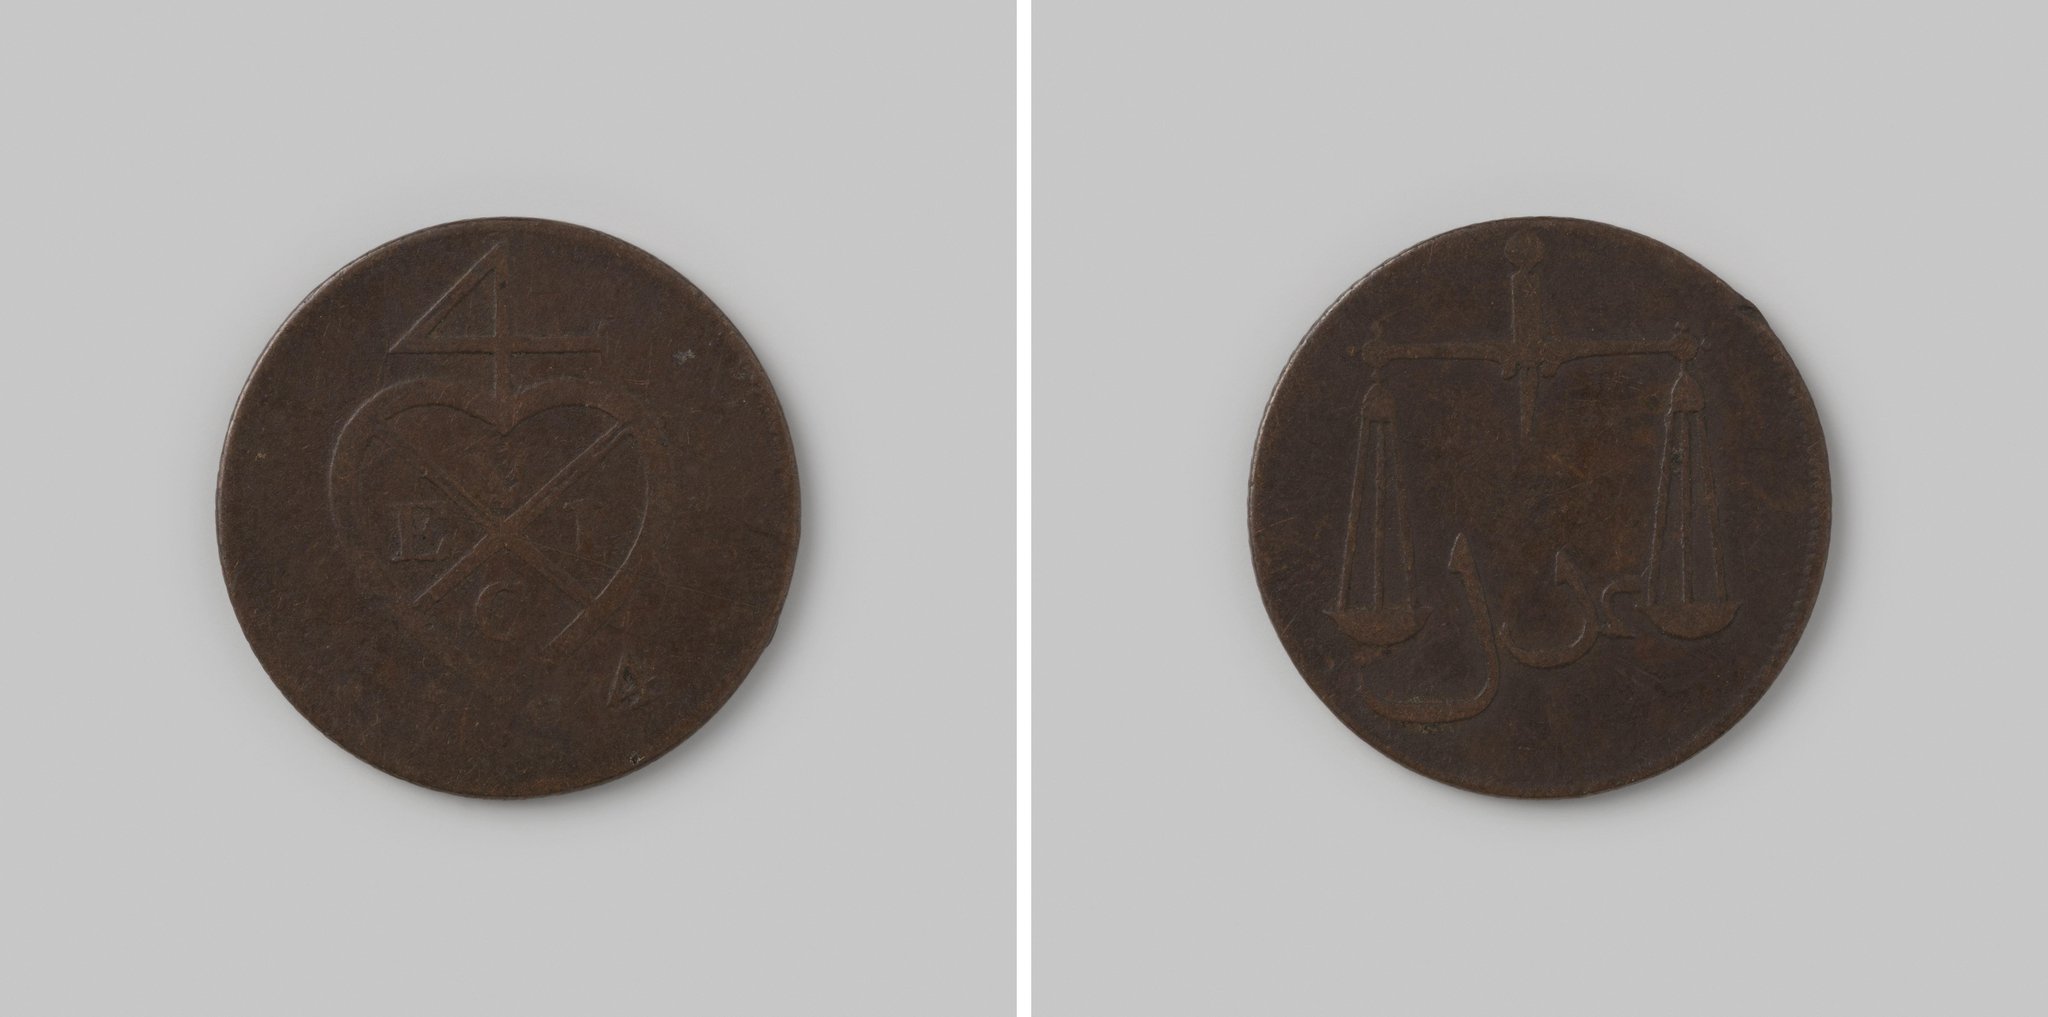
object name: coin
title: ½ pice voor Bombay in India van de Engelse Oostindische Compagnie (EIC), 1794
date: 1794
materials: copper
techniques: striking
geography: birmingham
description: Koperen munt. Voorzijde: merk van de EIC met onderaan jaartal. Keerzijde: weegschaal met tussen de twee schalen opschrift in Arabische lettertekens: adl [=rechtvaardig]. Kabelrand